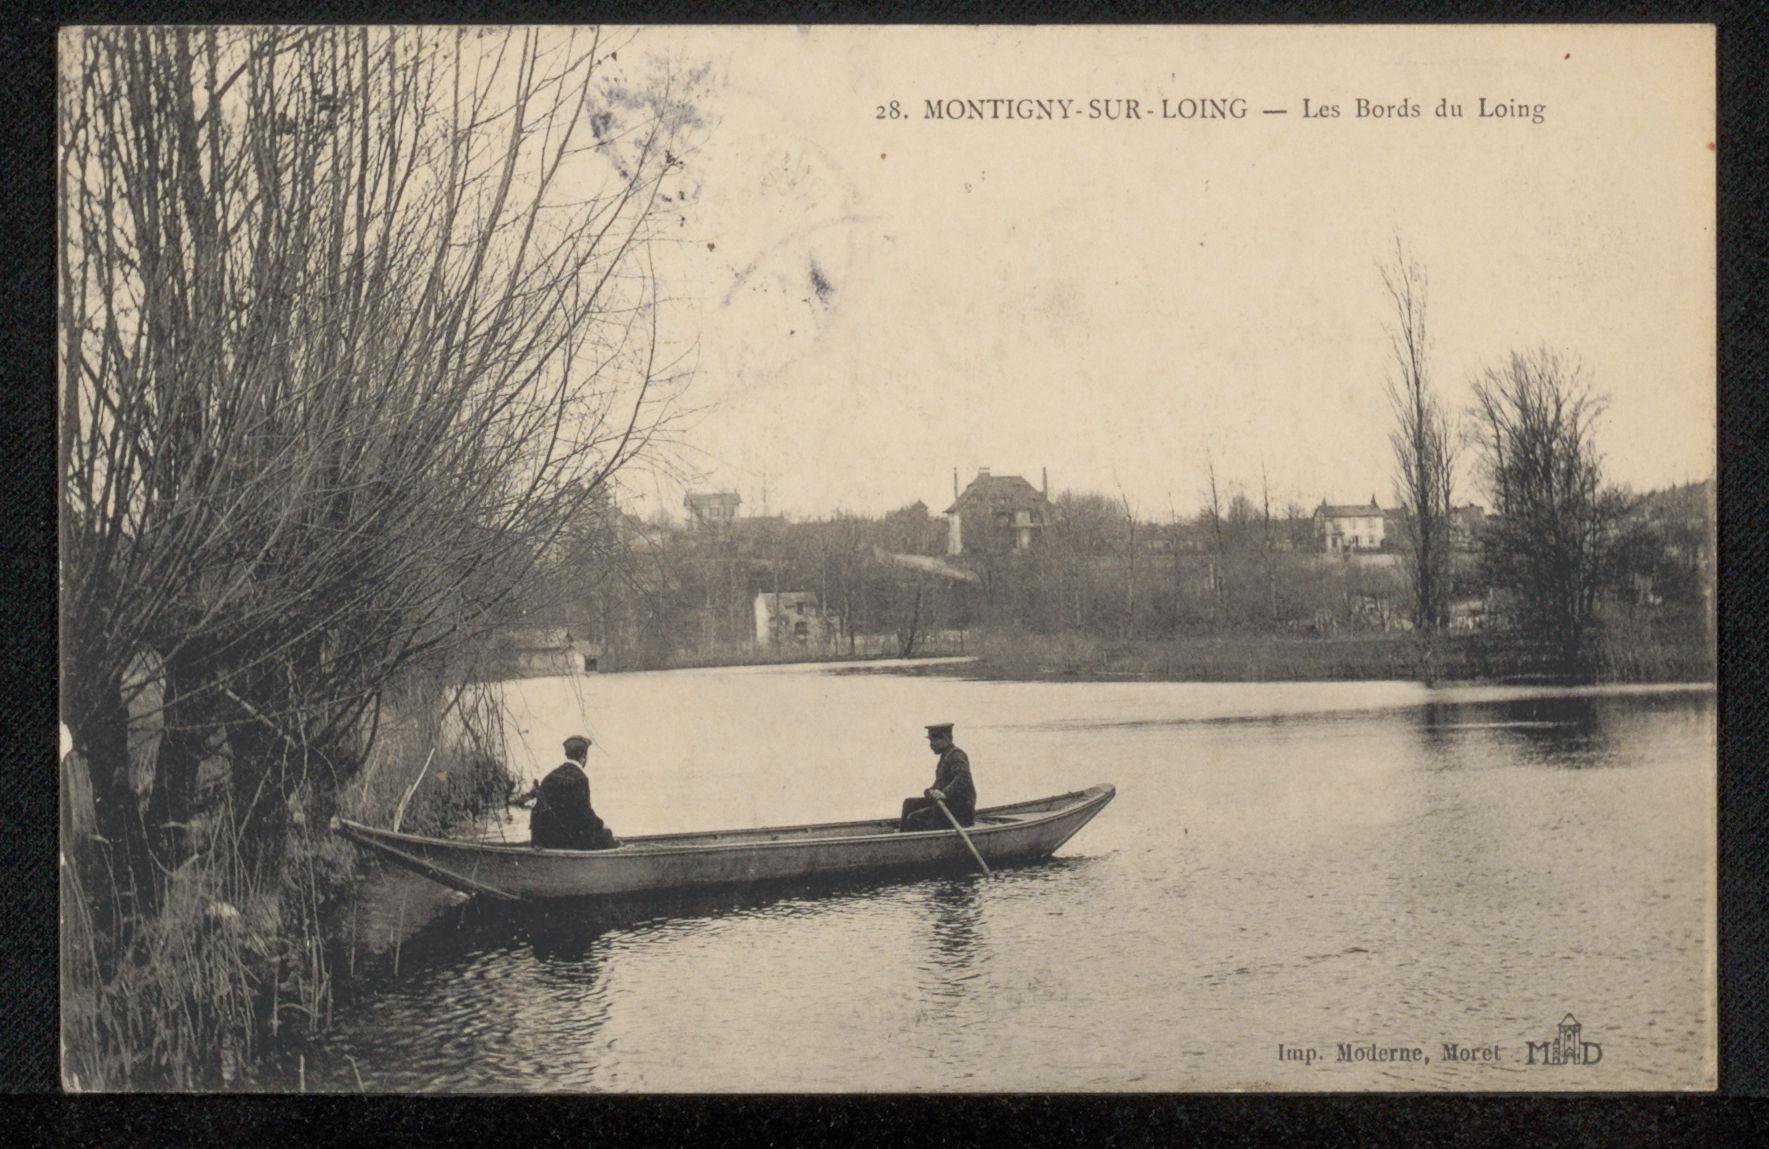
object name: ansichtkaart, prentbriefkaart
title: Prentbriefkaart aan Philip Zilcken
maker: gabriel mourey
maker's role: criticus, schrijver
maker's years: 1865-1943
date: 1911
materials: cardboard, ink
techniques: photograph, pen, writing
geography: montigny-sur-loing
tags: the hague, painter, draughtsman, philip zilcken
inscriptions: collector's mark: ‘RPK’